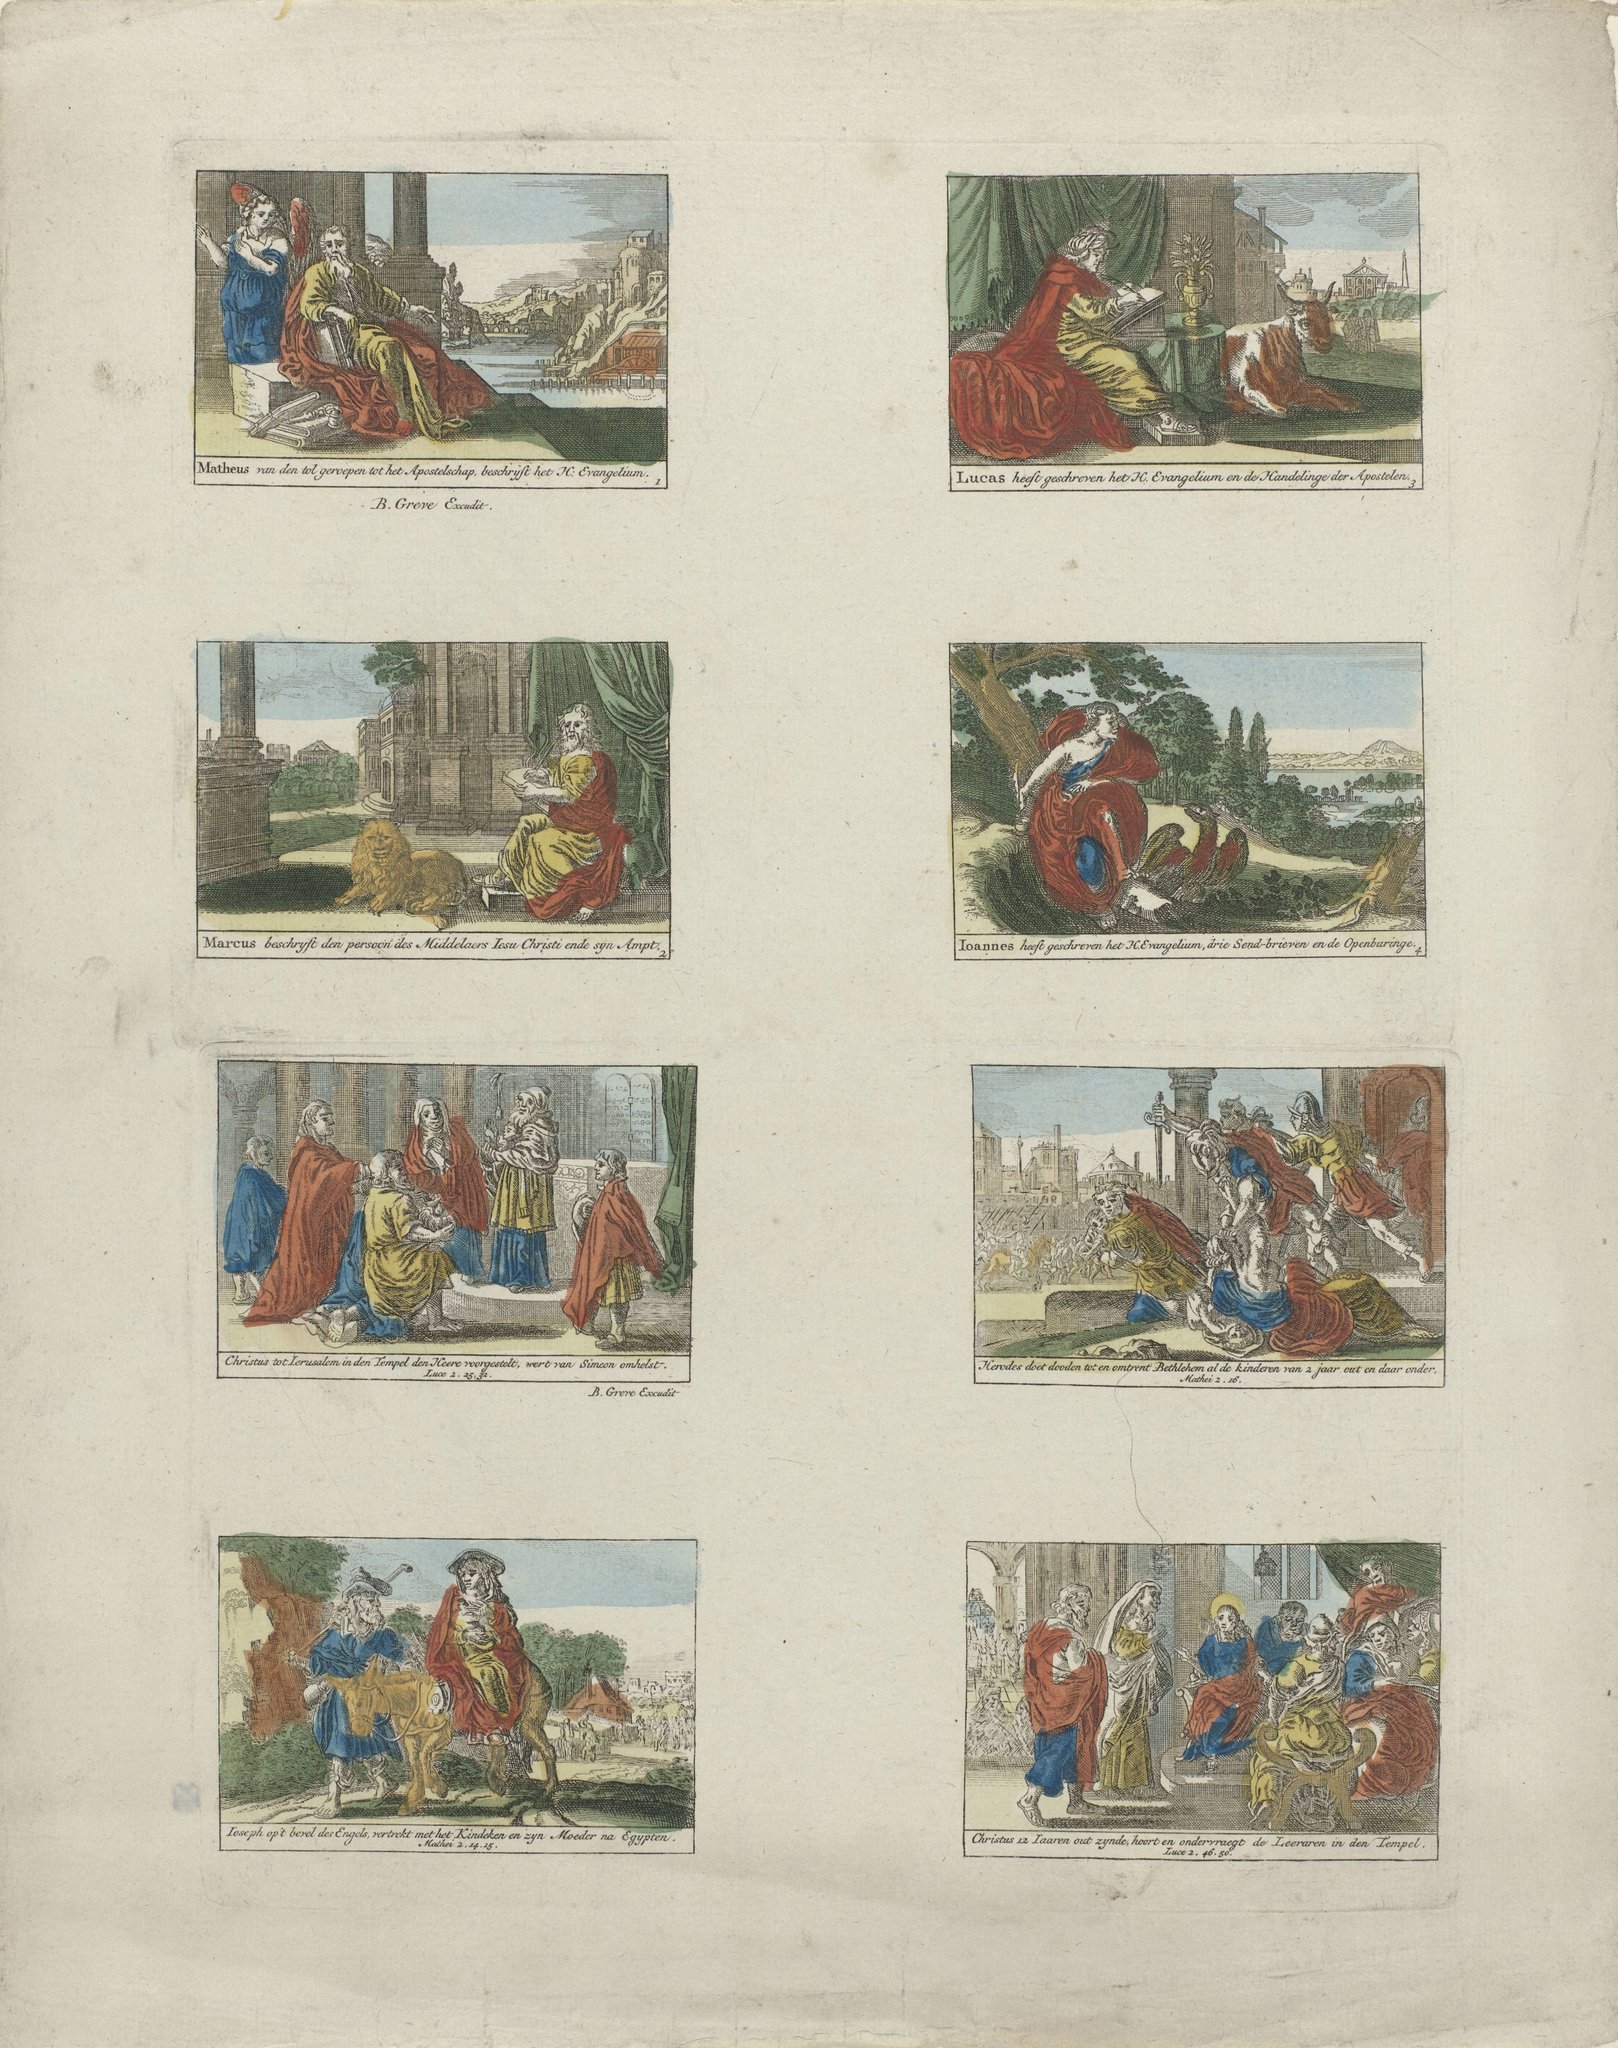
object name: print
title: Acht Bijbelse voorstellingen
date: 1745-1751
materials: paper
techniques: colour, engraving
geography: amsterdam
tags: evangelists, usually with books or scrolls (not in biblical context), the four symbols of the evangelists, 'the apocalyptic beasts', new testament, the evangelists writing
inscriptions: collector's mark: Lugt 2760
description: Blad met 8 voorstellingen, waaronder vier voorstellingen van de Evangelisten met hun attribuut in een landschap of klassieke architectuur, en vier scènes uit het Nieuwe Testament. Onder elke voorstelling een titel, en soms het bijbehorende bijbelcitaat.